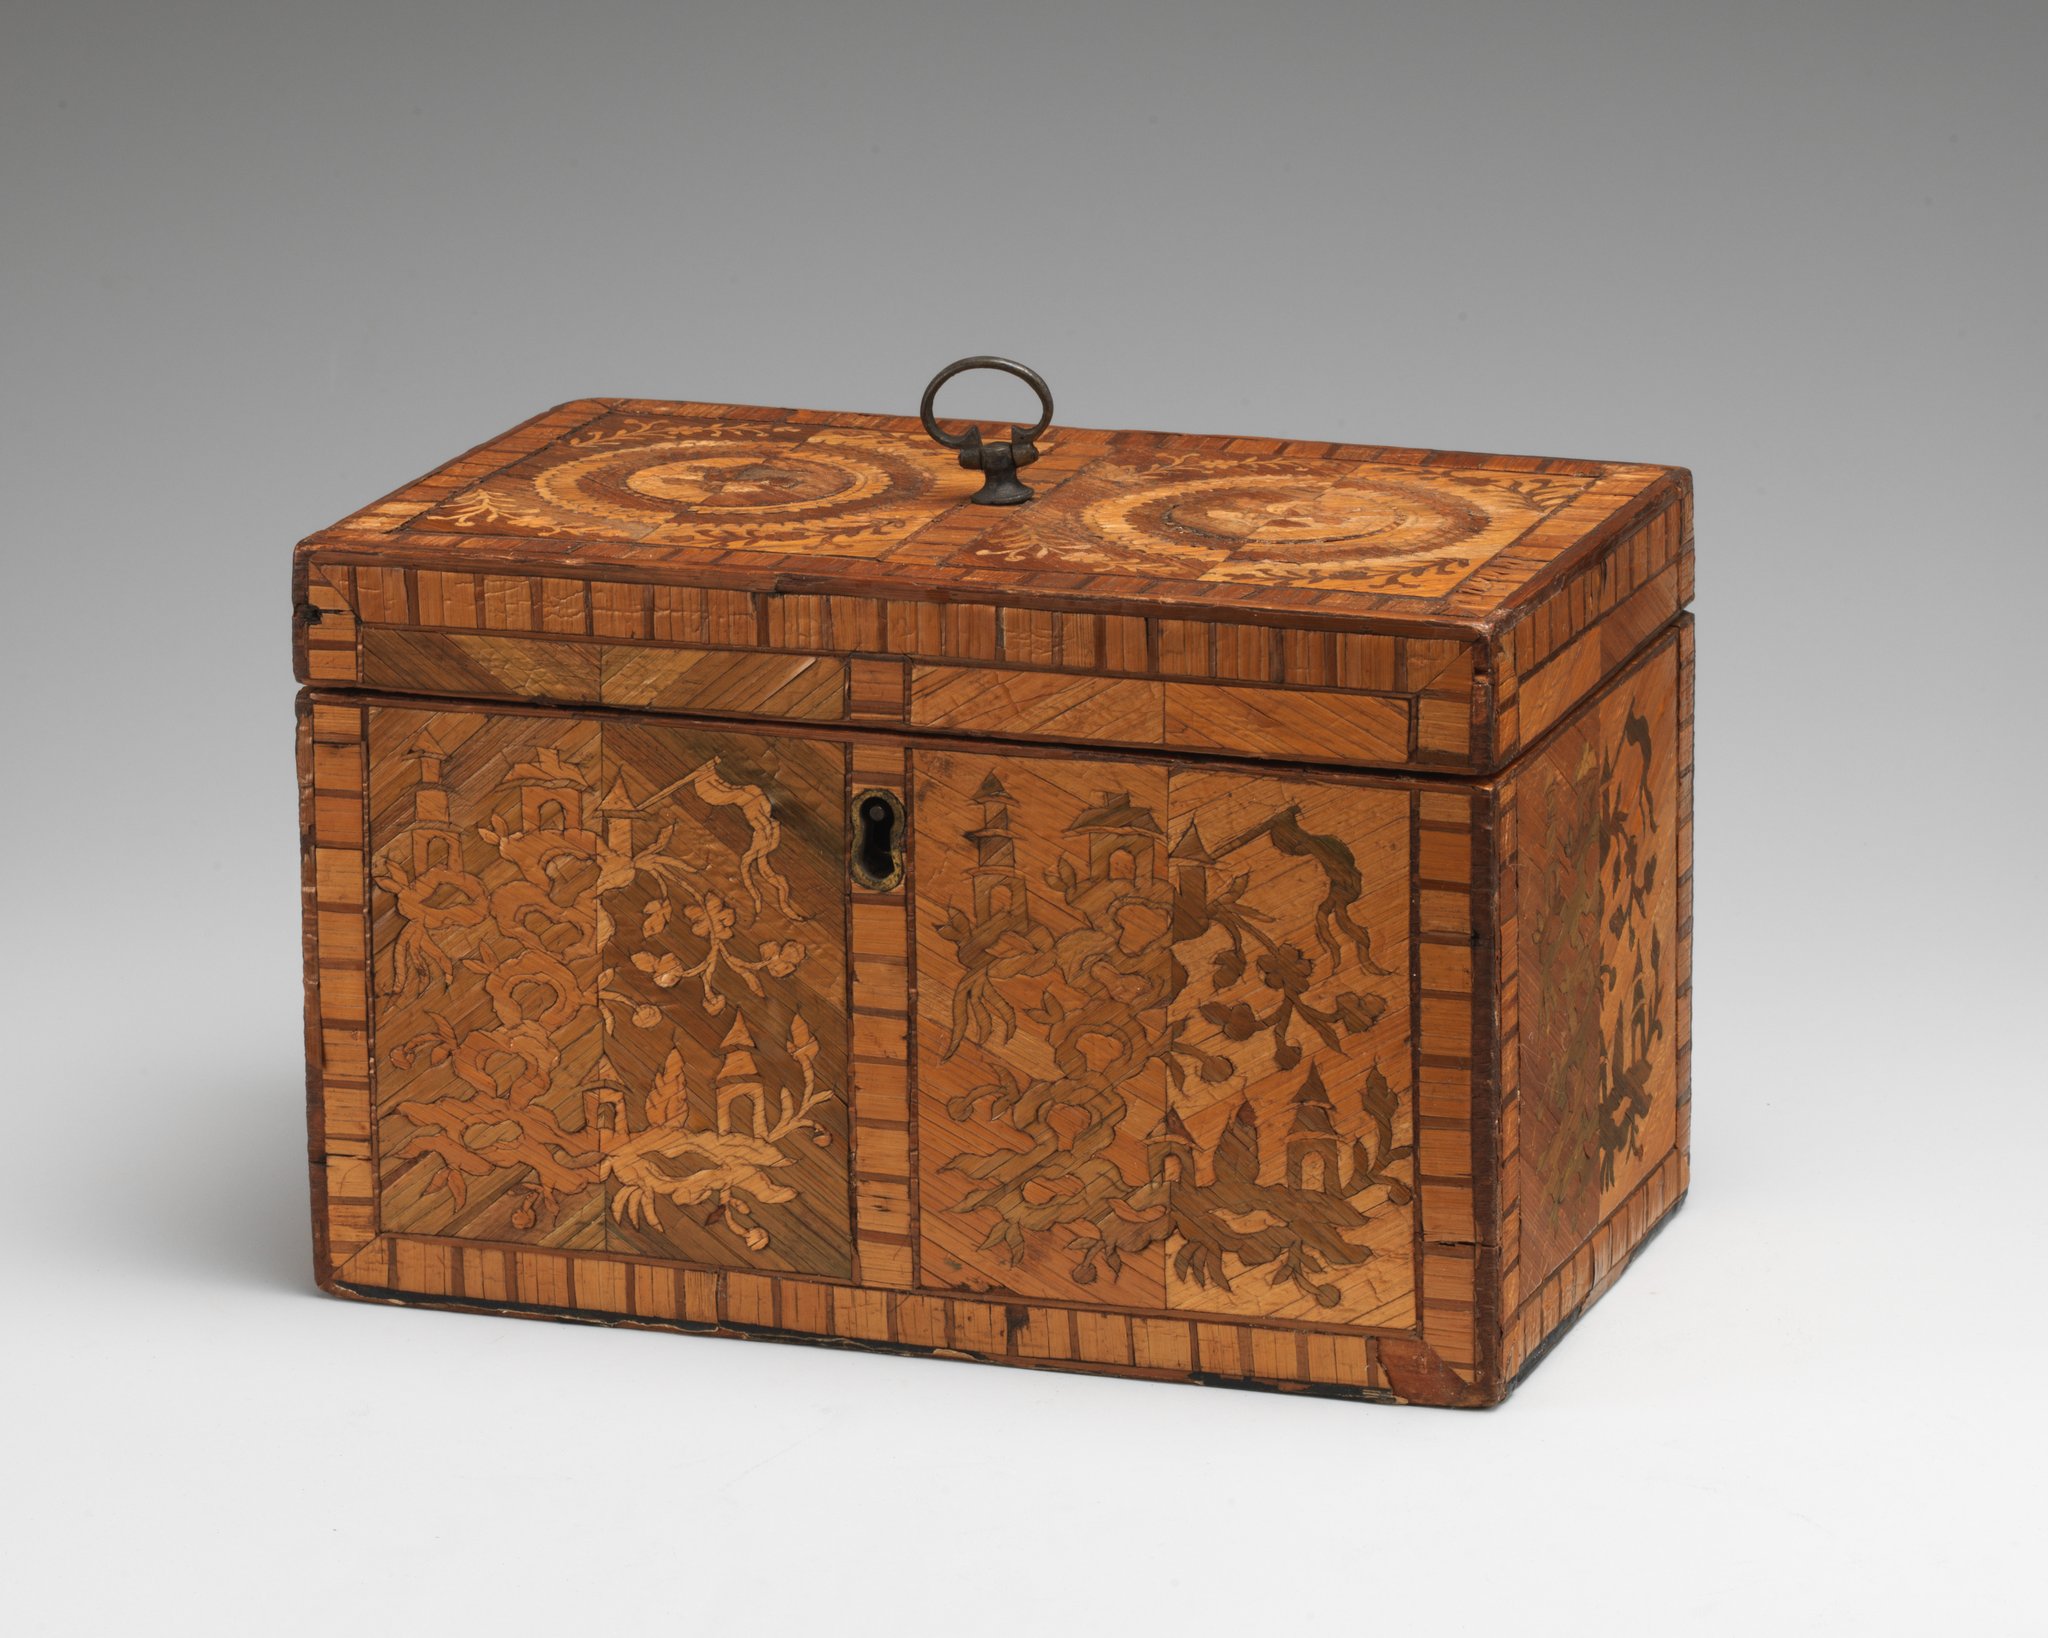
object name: tea caddy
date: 1751-1775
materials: paper, silver, fiber, wood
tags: chinoiserie